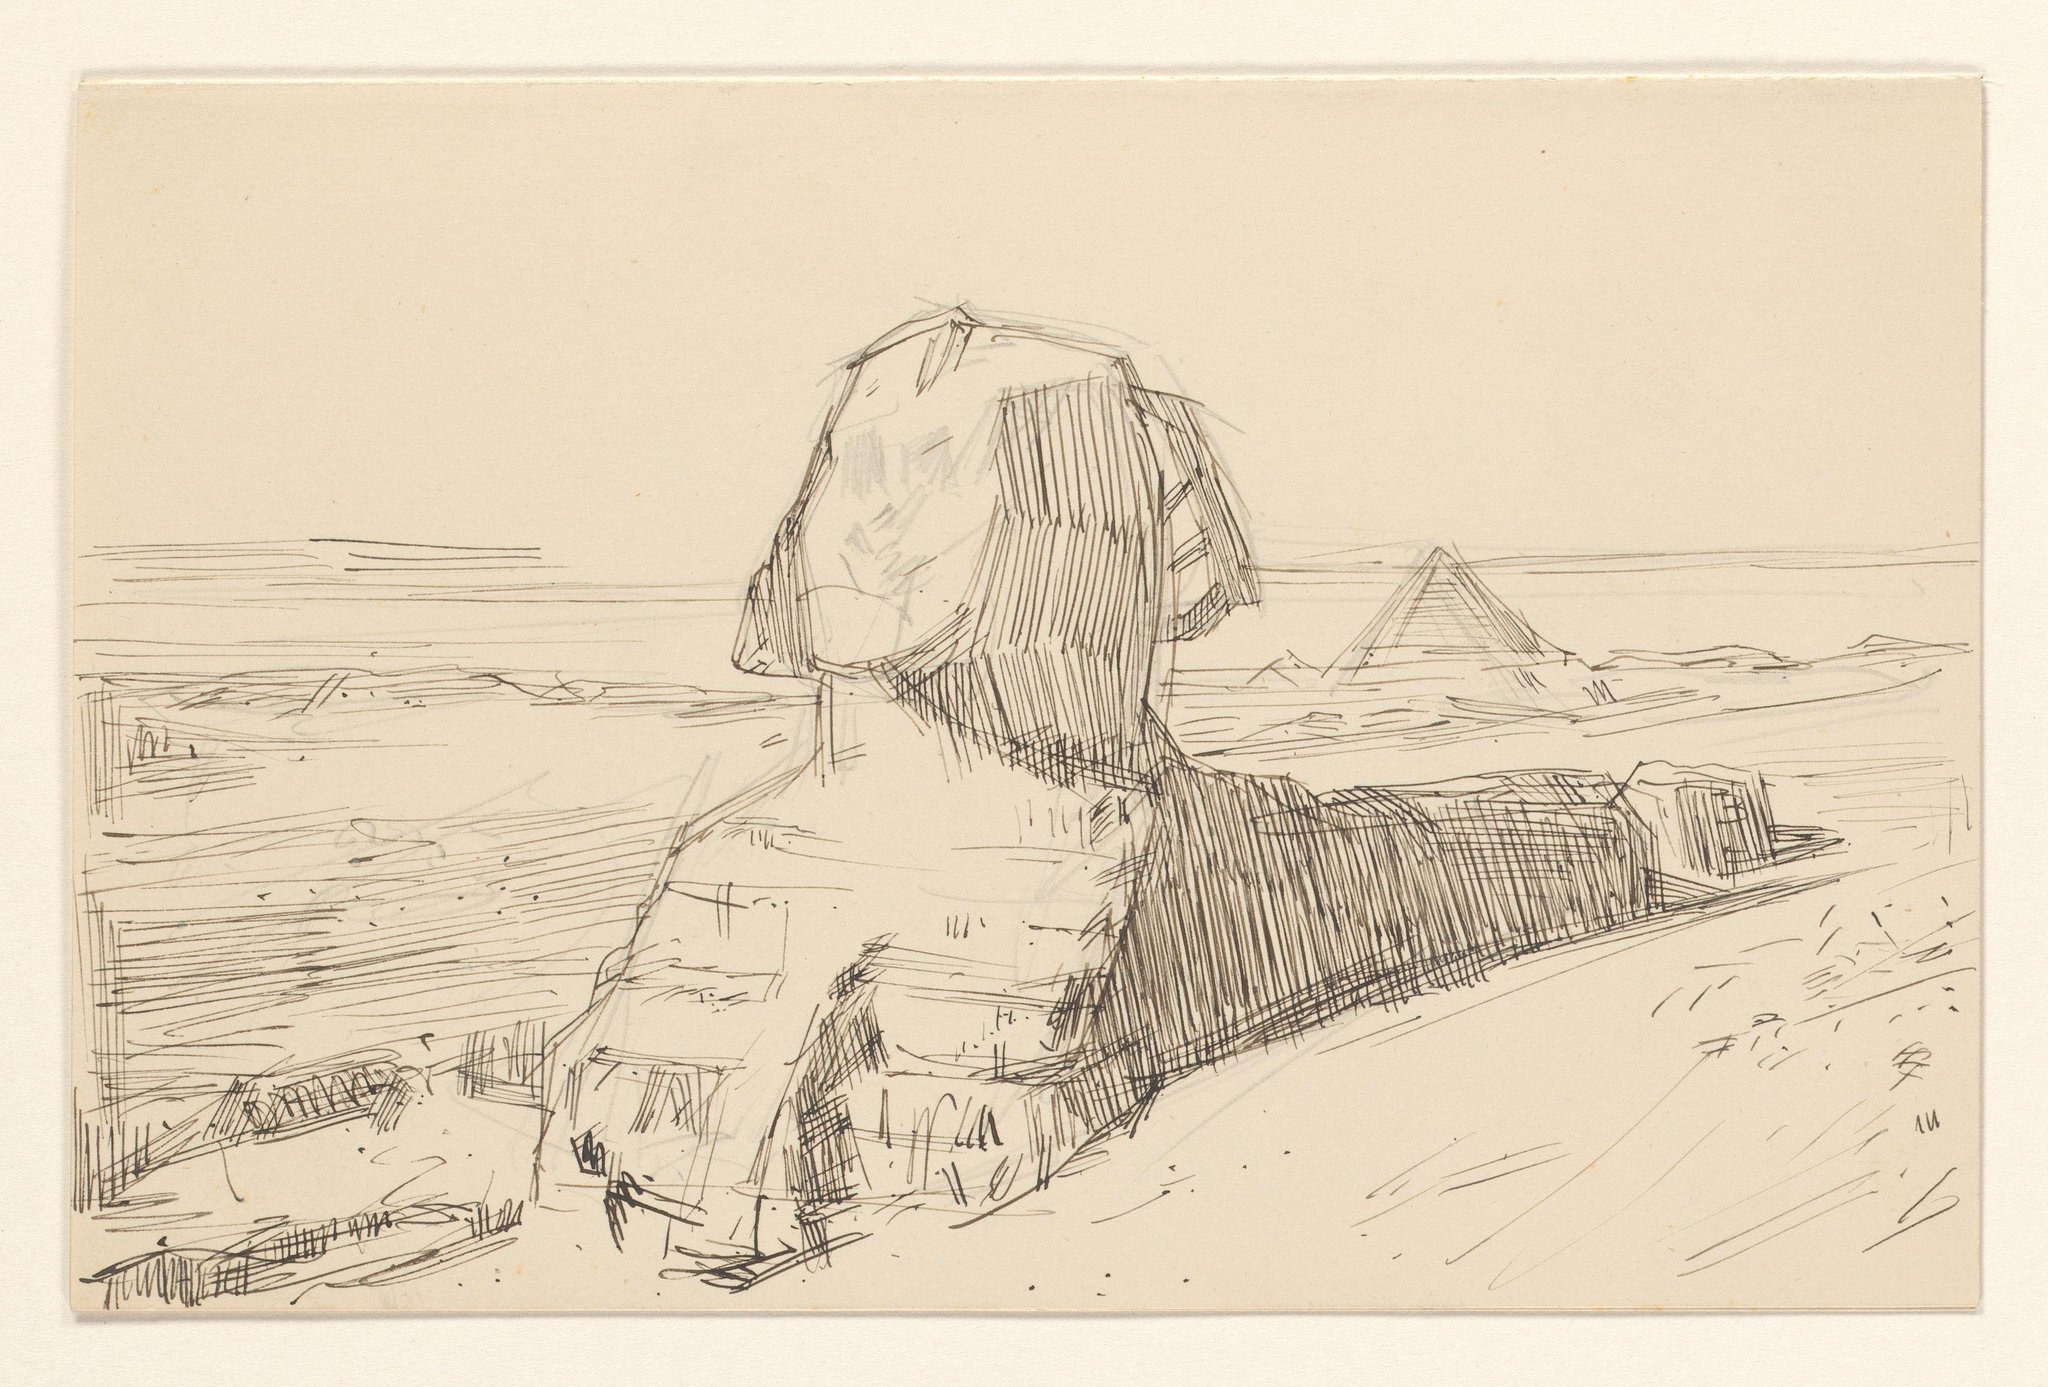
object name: drawing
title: Studie van een Sphinx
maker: august allebé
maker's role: draughtsman, print maker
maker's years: 1838-1927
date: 1848-1927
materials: ink, paper, pencil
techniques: pen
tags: sphinx (lion/woman); 'sfinge' (ripa), piece of sculpture, reproduction of a piece of sculpture